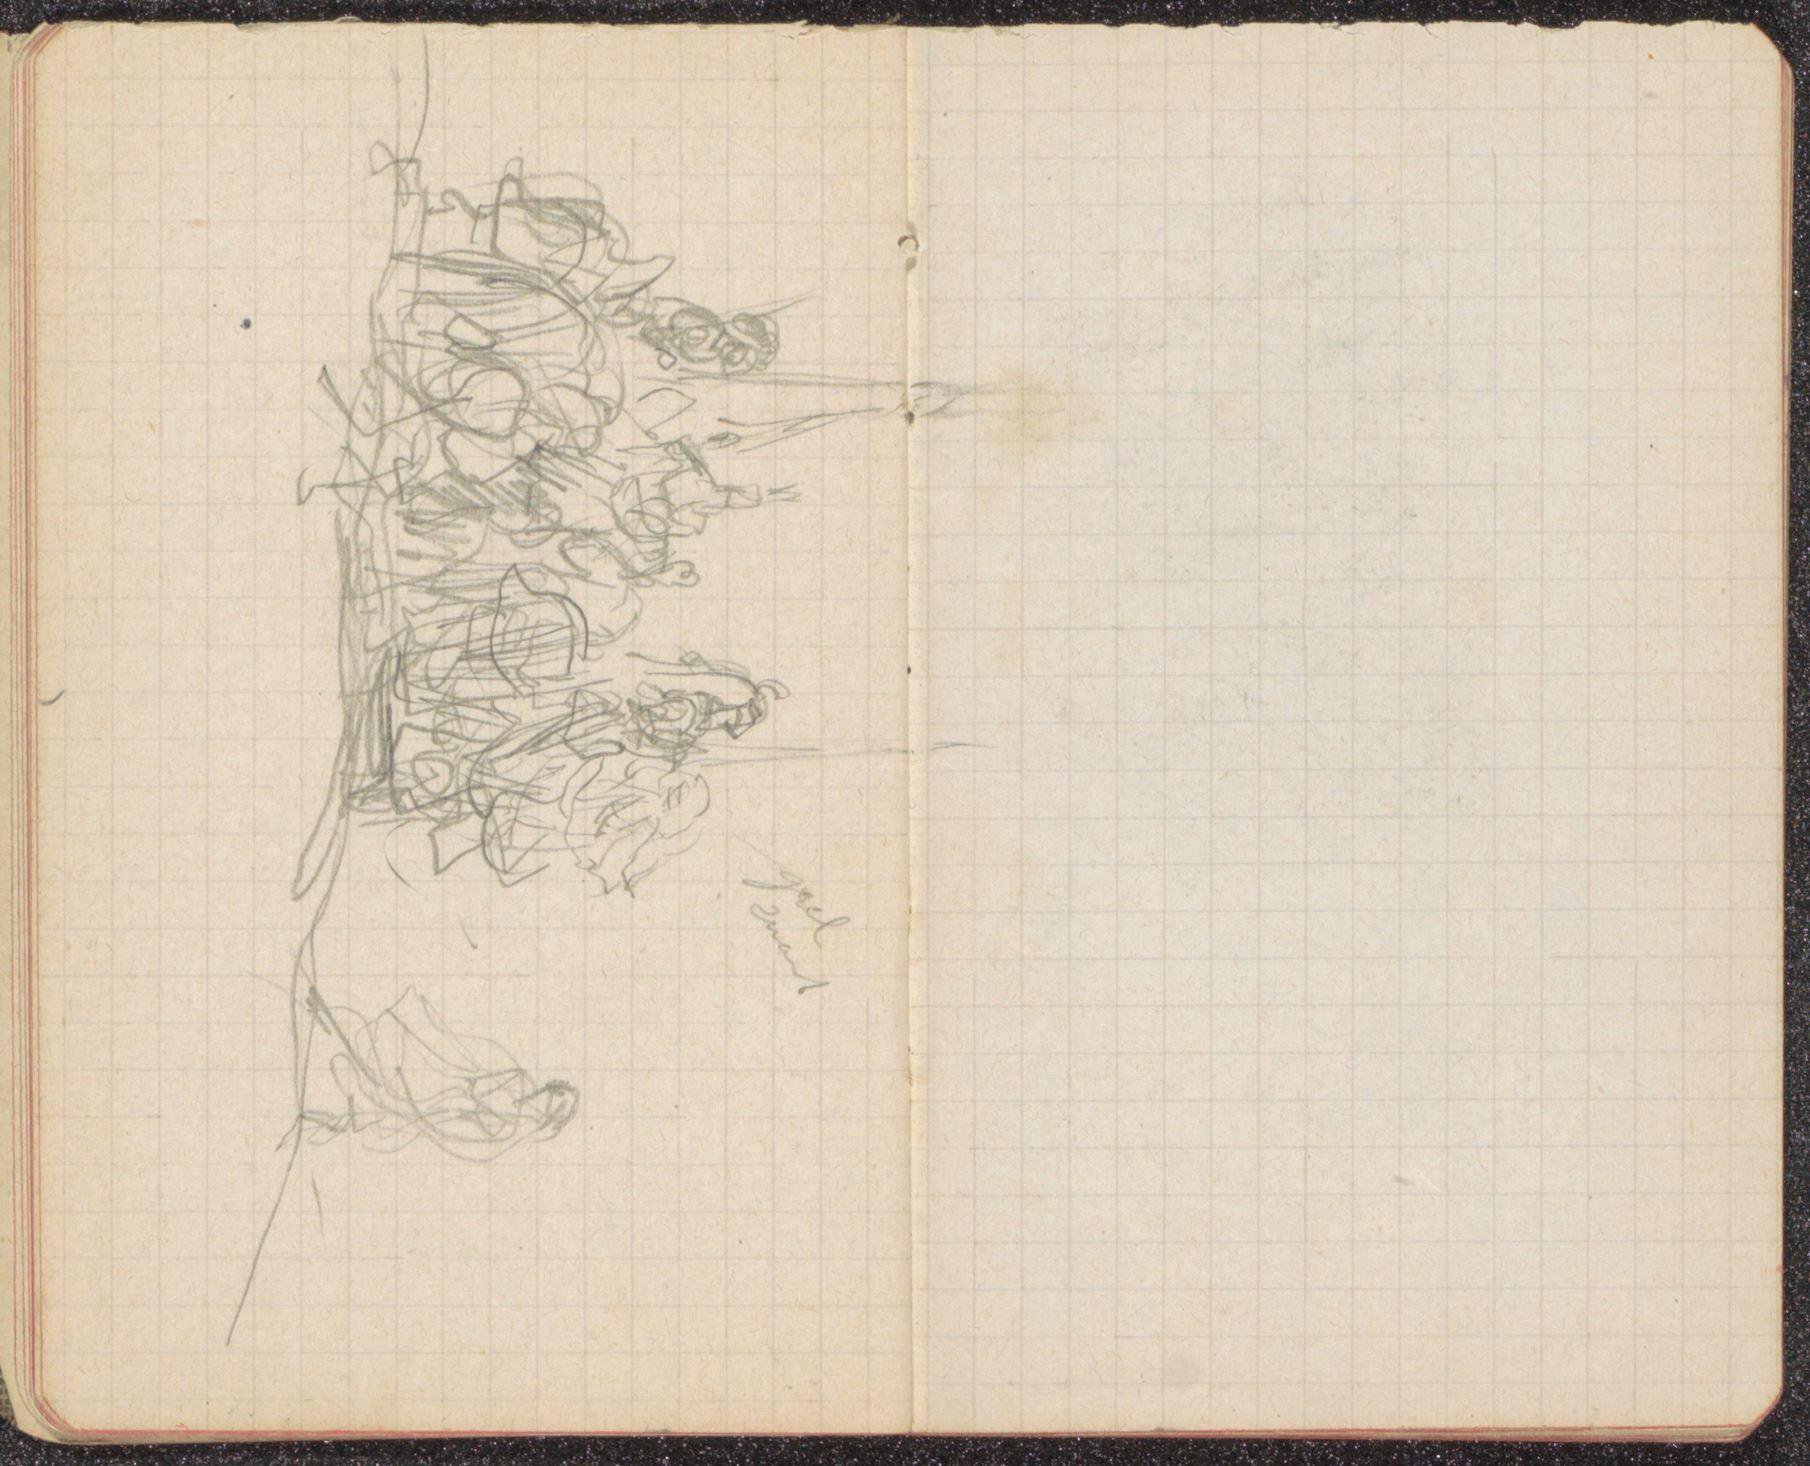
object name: sketchbook leaf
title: Optocht van ruiters met vlaggen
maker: marius bauer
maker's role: draughtsman, print maker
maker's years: 1867-1932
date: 1902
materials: pencil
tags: riding a horse, ass, or mule; rider, horseman, walking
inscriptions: kleurnotitie, handgeschreven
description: Enkele lopende figuren begeleiden de stoet. Pagina 16 en 17 uit een schetsboek met 23 bladen.